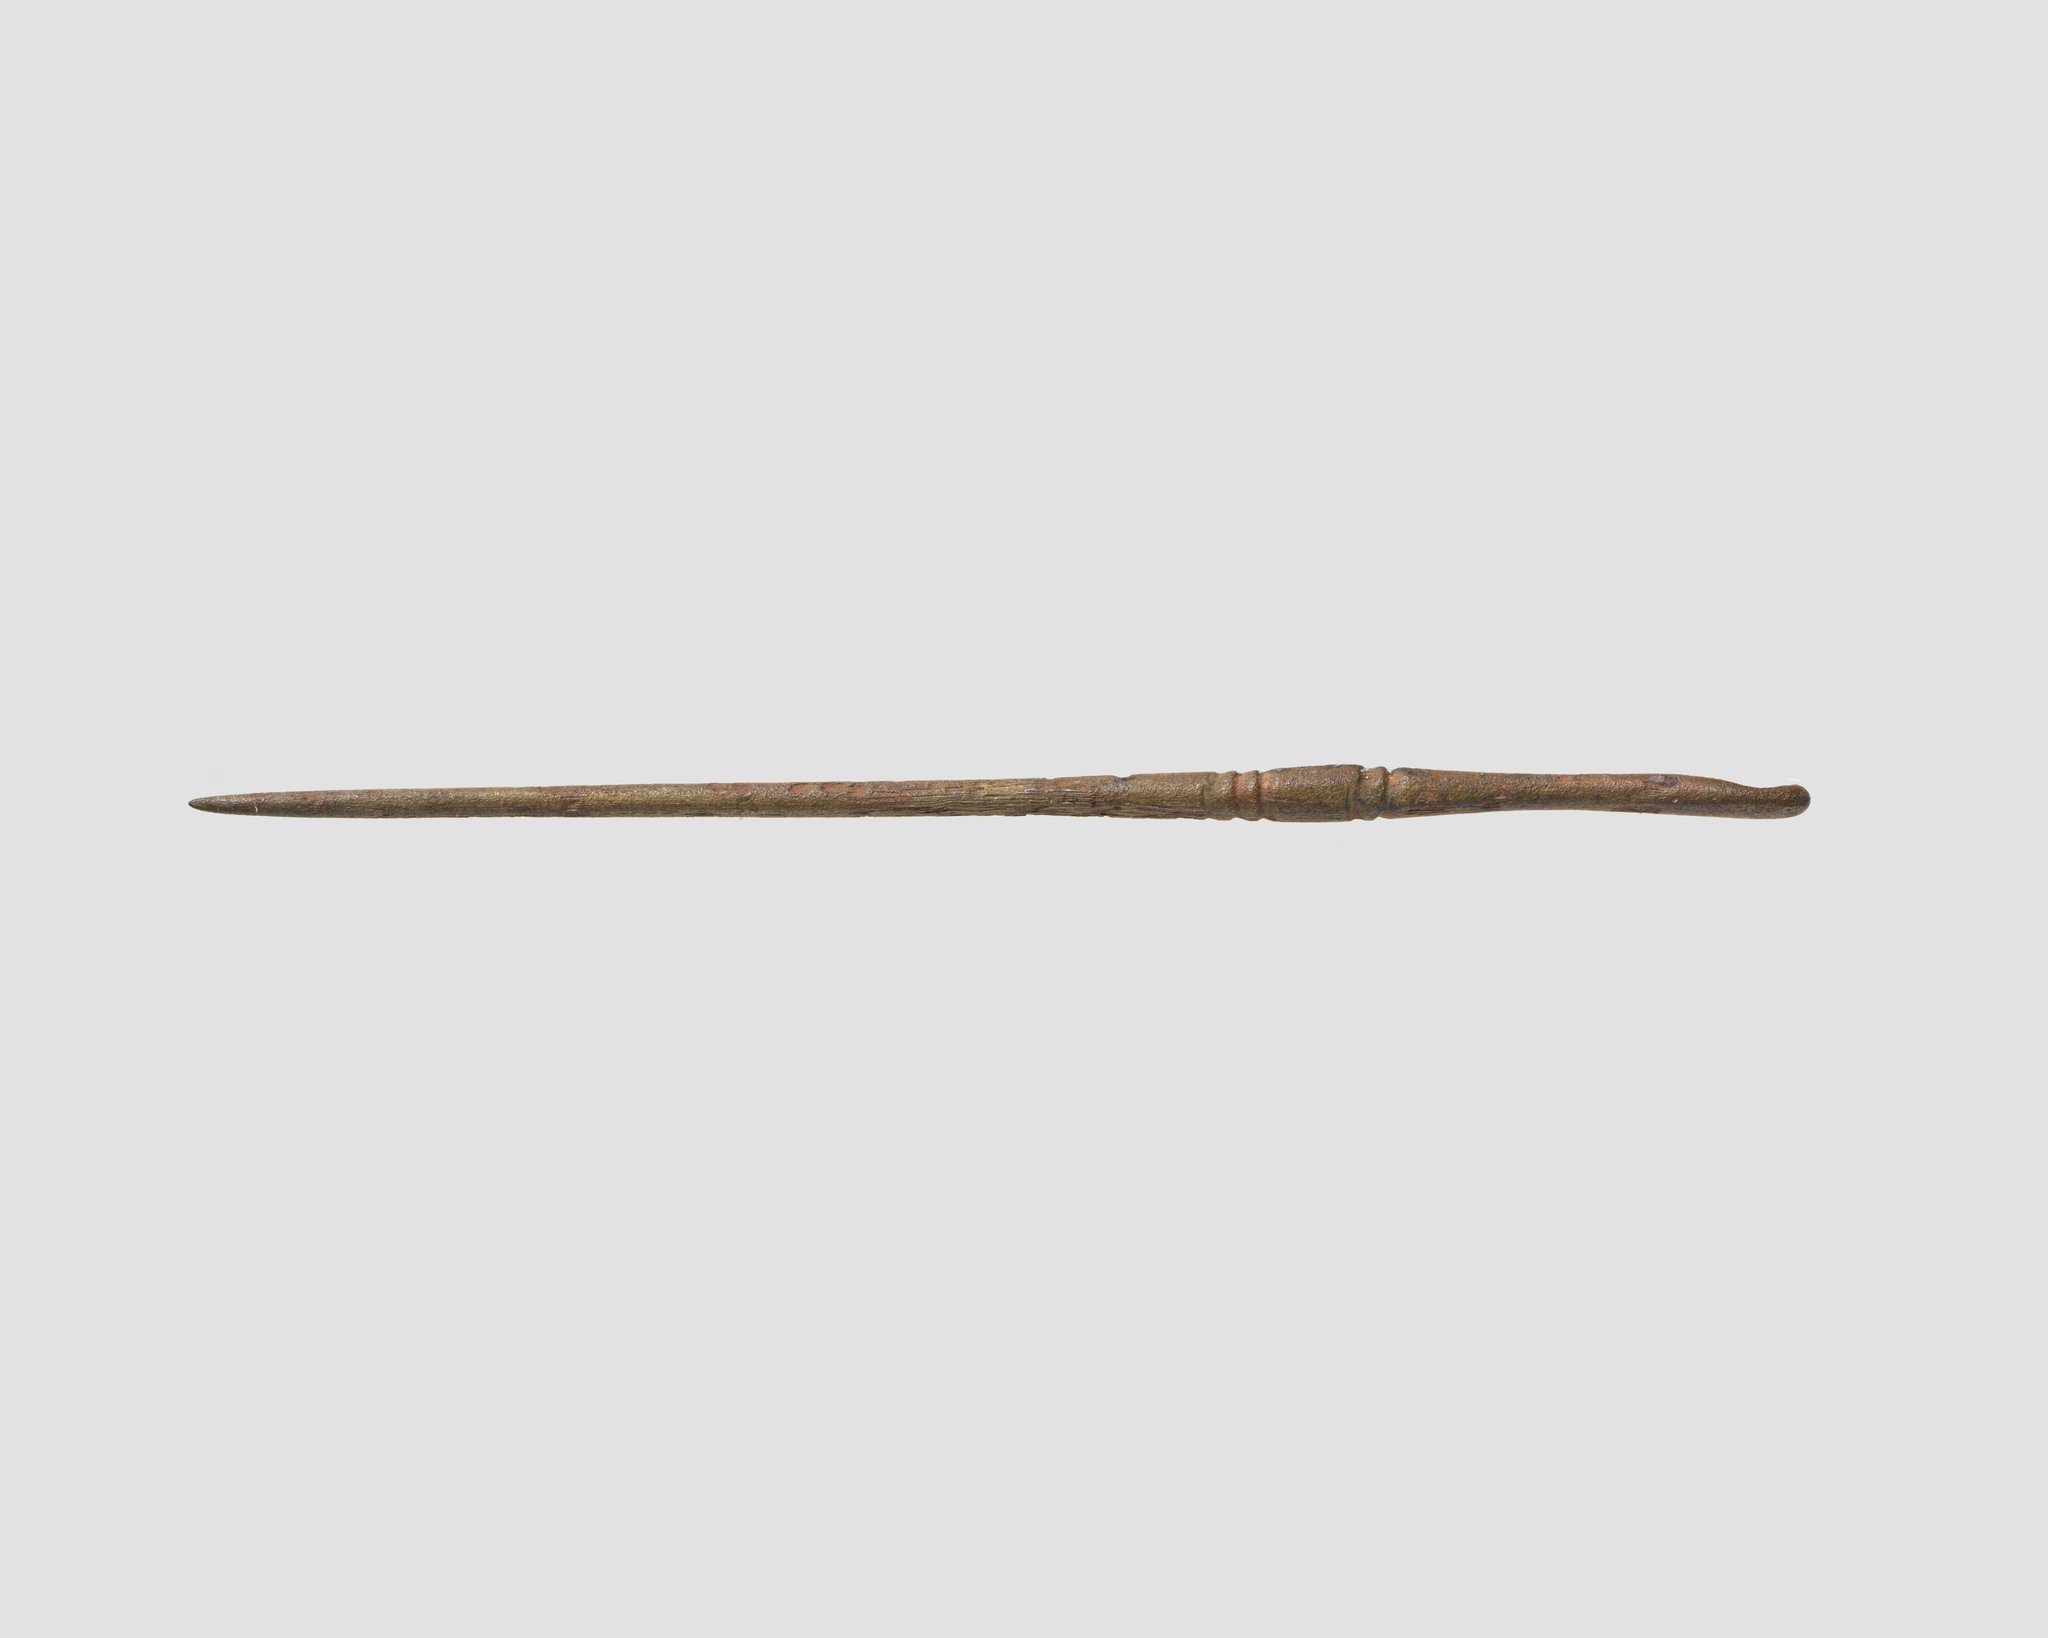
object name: cosmetic spoon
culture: sasanian or islamic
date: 501-800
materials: bronze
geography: iran